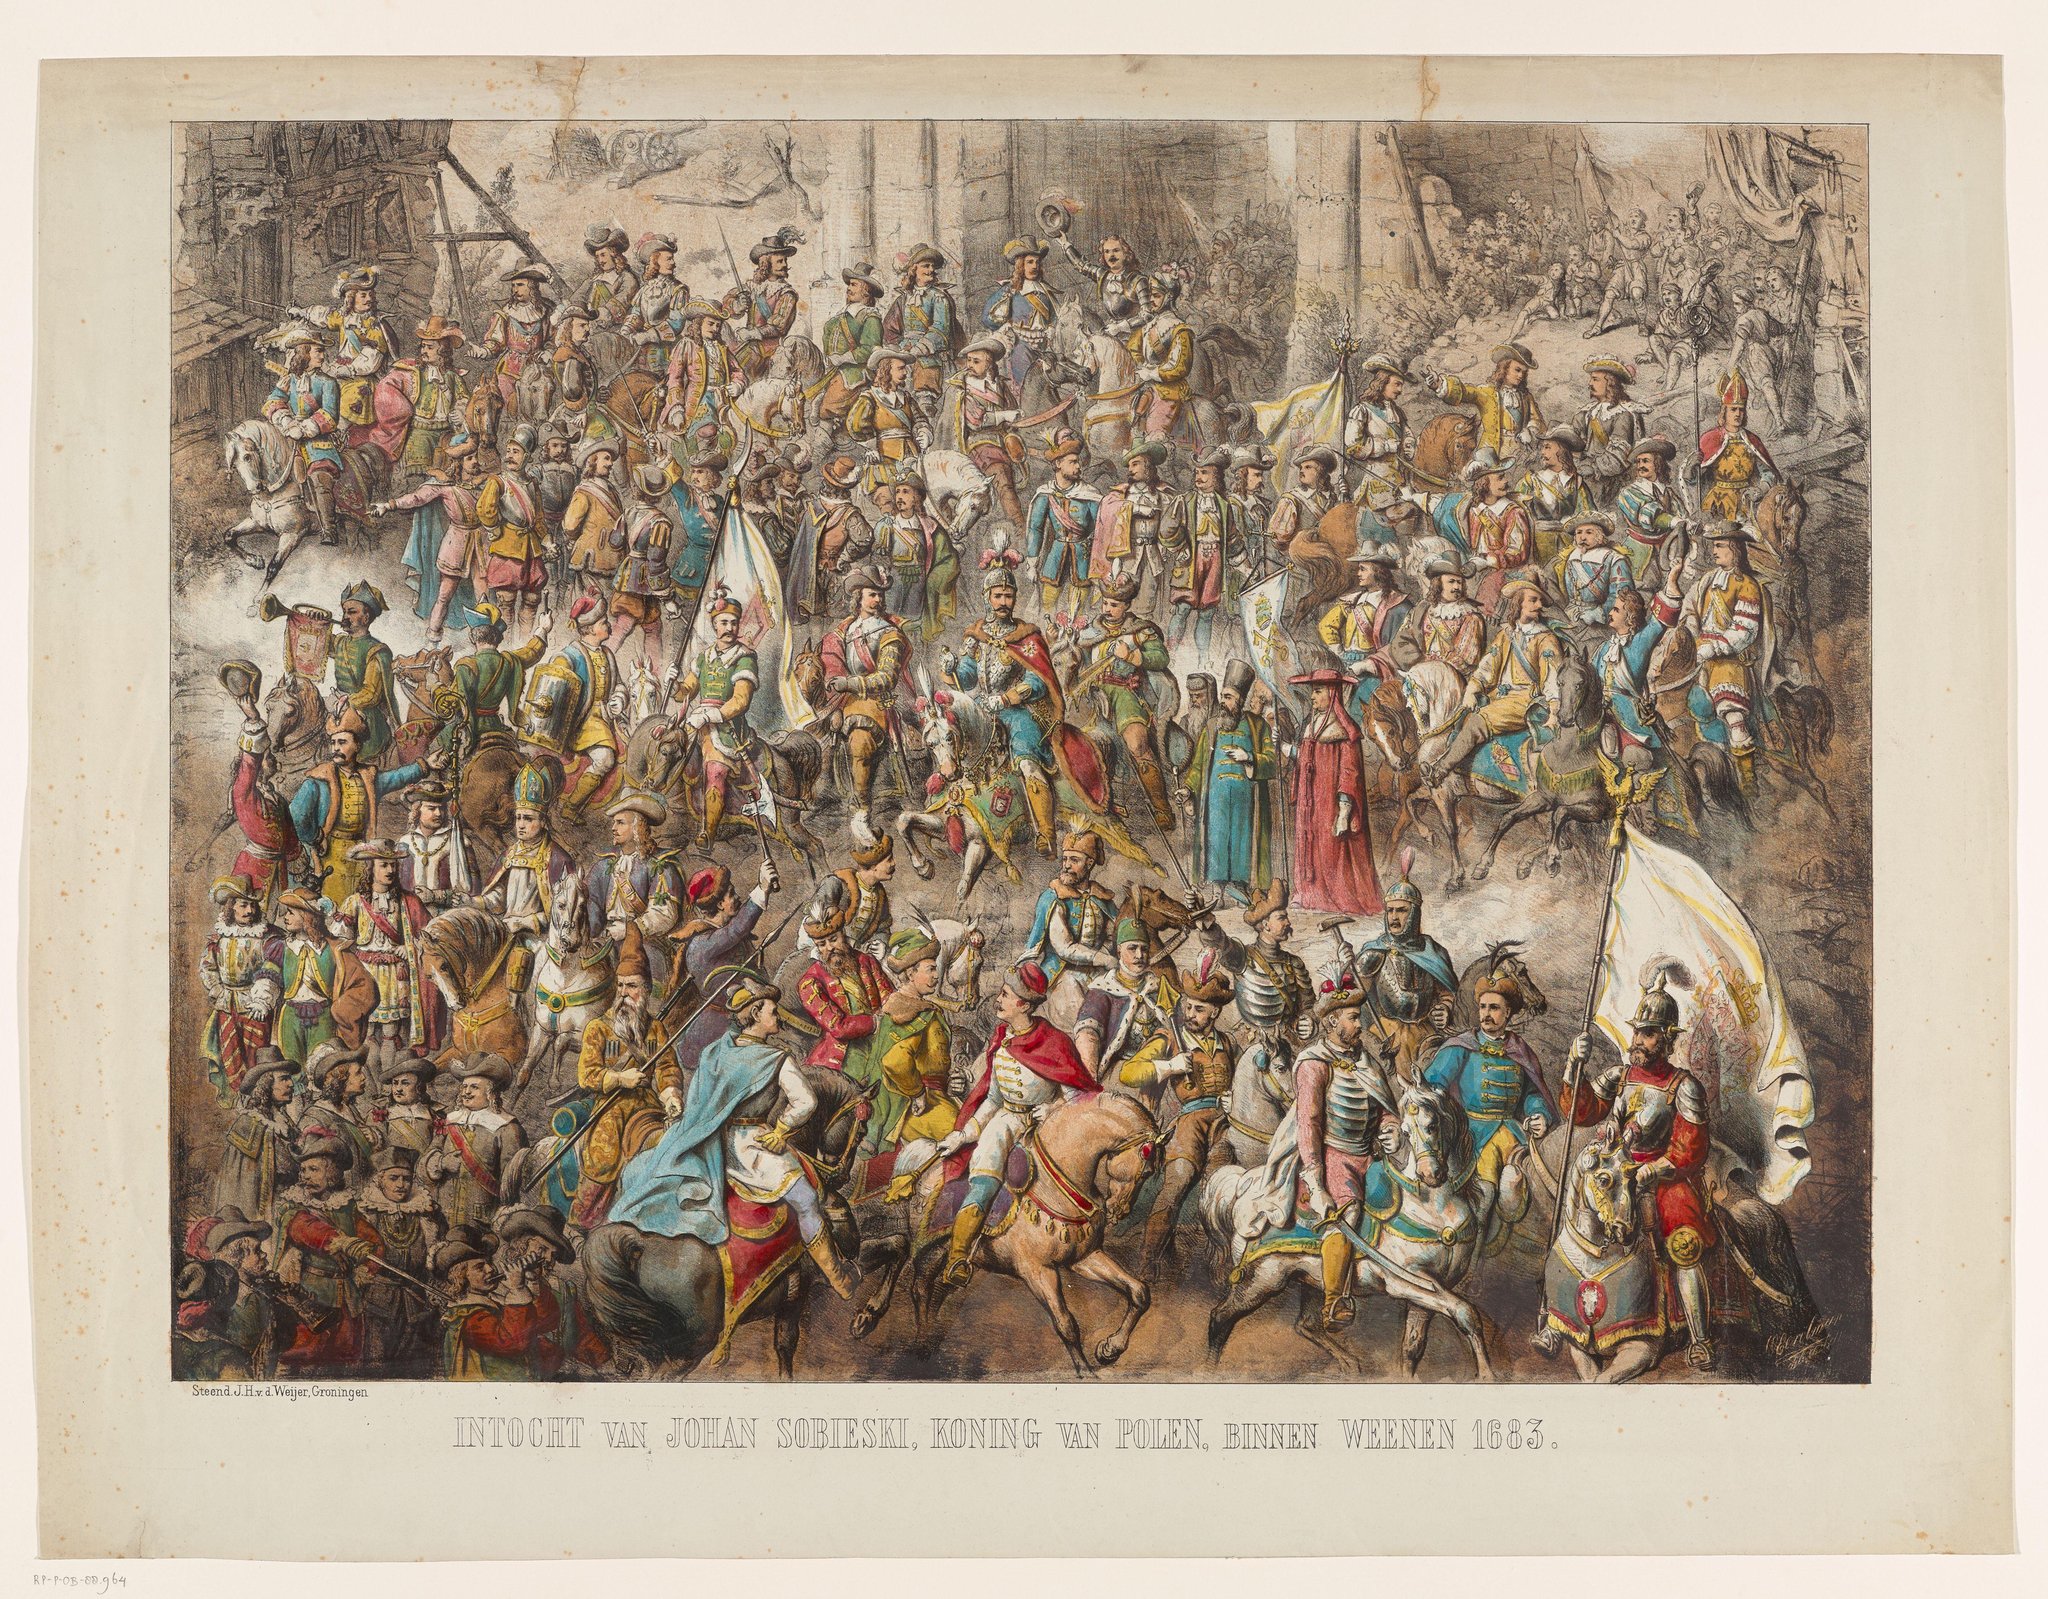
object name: print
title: Maskerade van de Groningse studenten, 1869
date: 1869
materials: lacquer, paper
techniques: chromolithography, lacquer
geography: groningen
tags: students' pageant, costumes used in pageants, commemoration of the founding of a university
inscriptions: collector's mark: Lugt 2228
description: Gekostumeerde historische optocht door de studenten van de Hogeschool van Groningen ter viering van de dies natalis op 22 september 1869. De optocht stelt voor de intocht van de Poolse koning Jan Sobieski binnen Wenen in 1683.